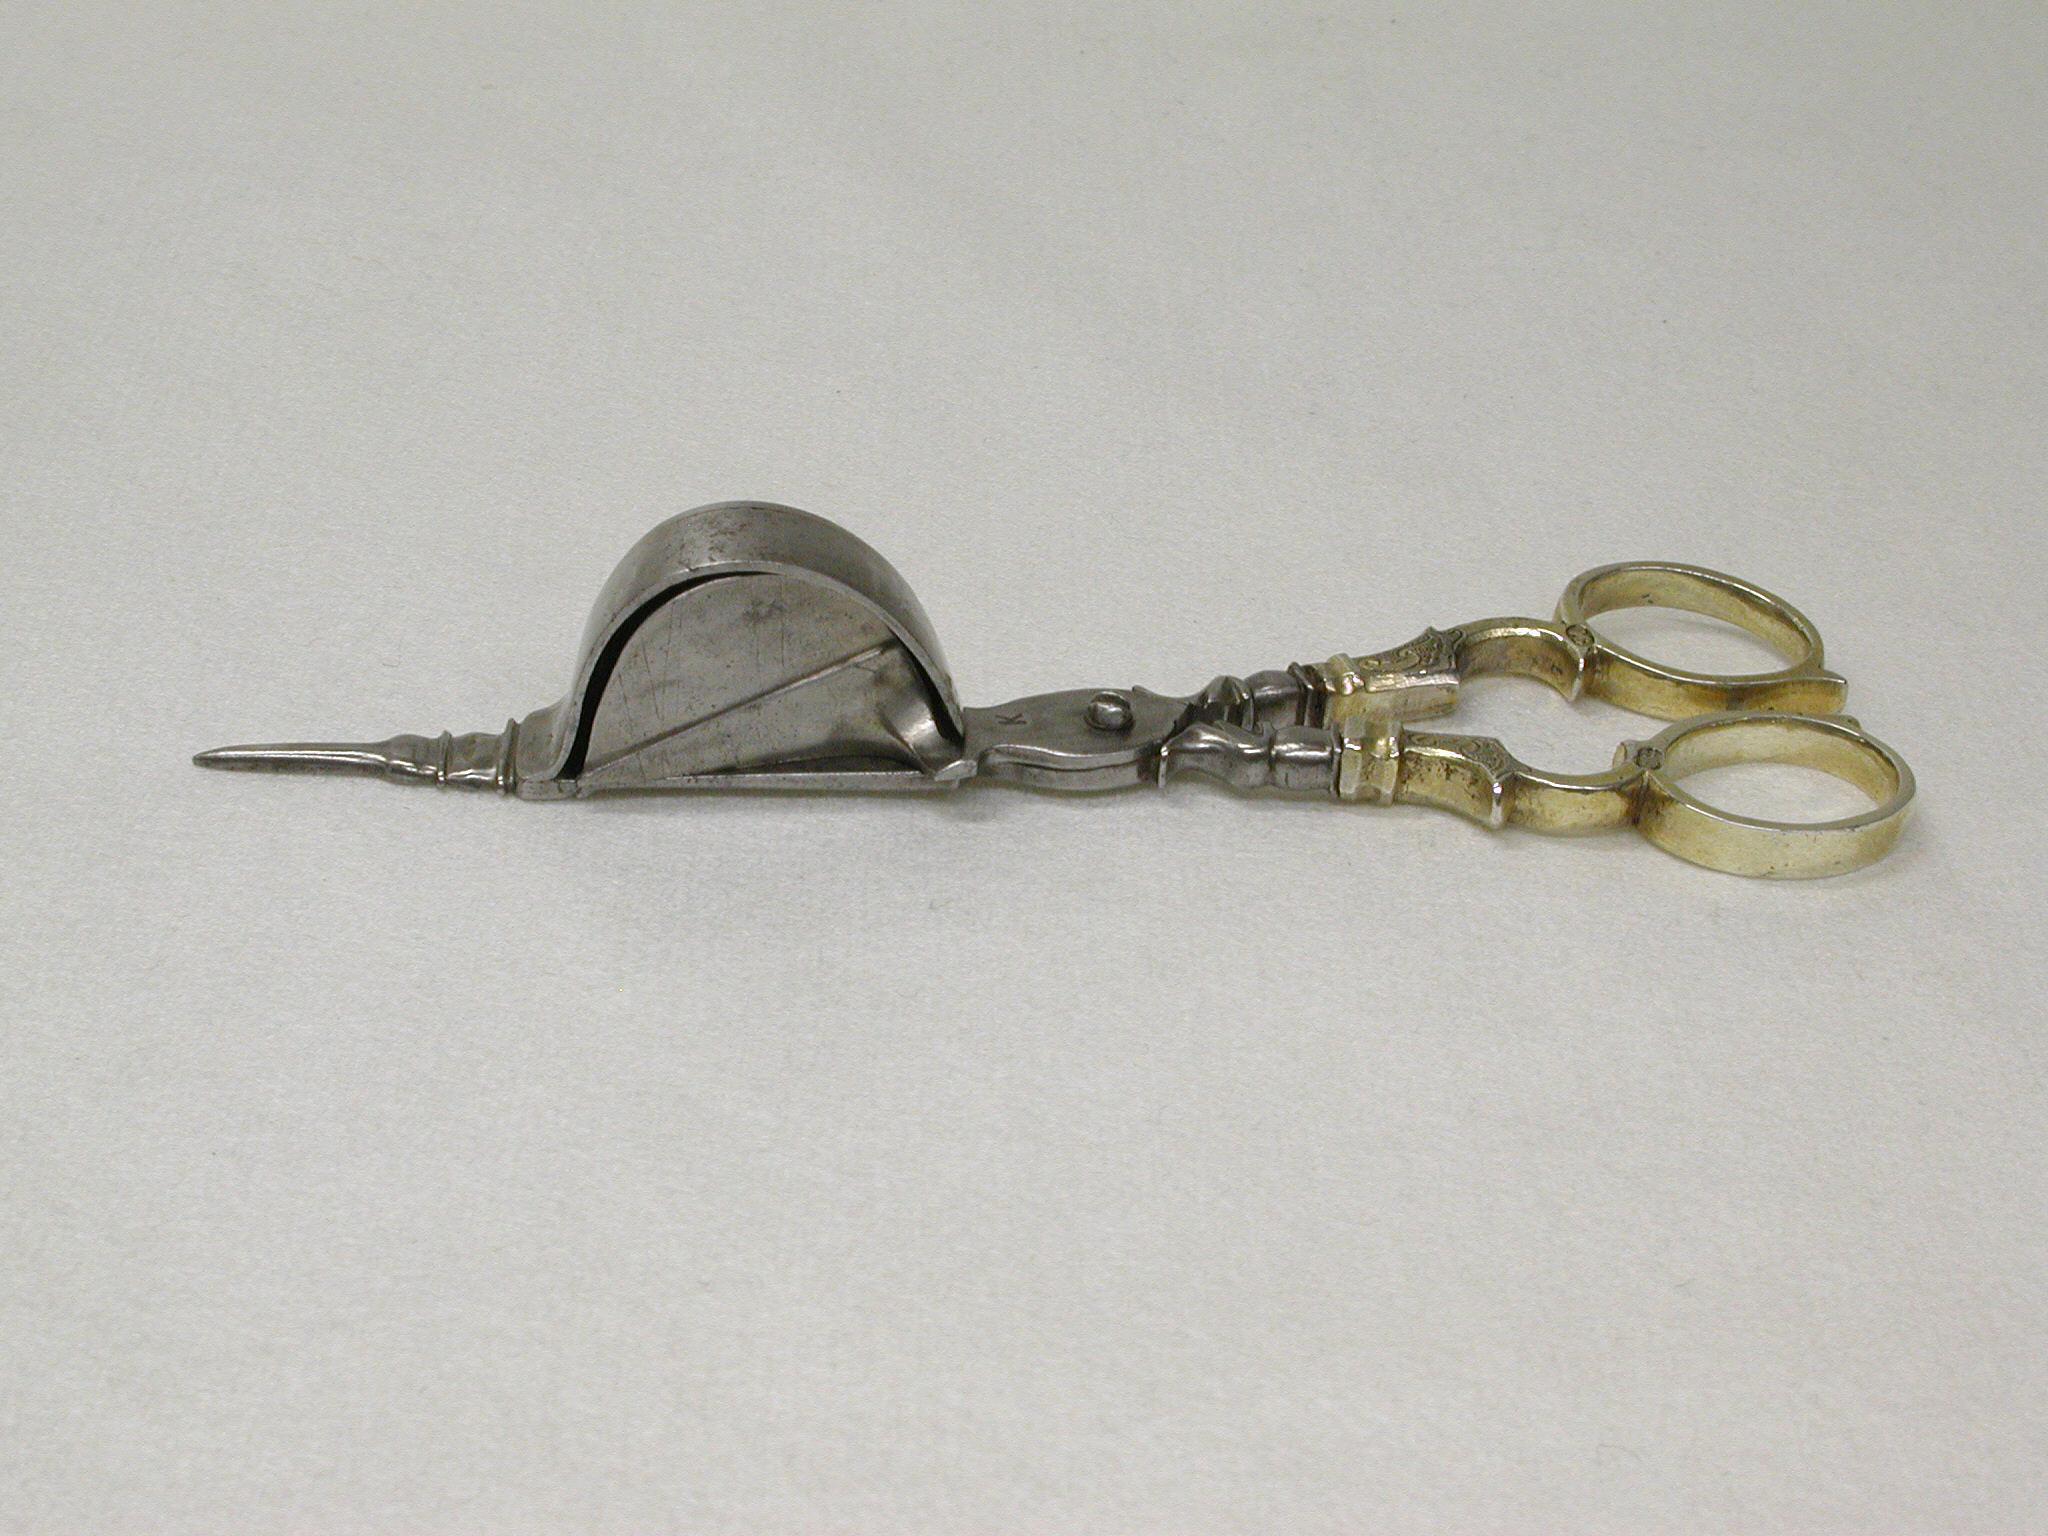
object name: snuffer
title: Snuffers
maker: friedrich schwestermuller ii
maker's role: maker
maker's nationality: german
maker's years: 1713-1752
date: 1743-1745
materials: silver gilt